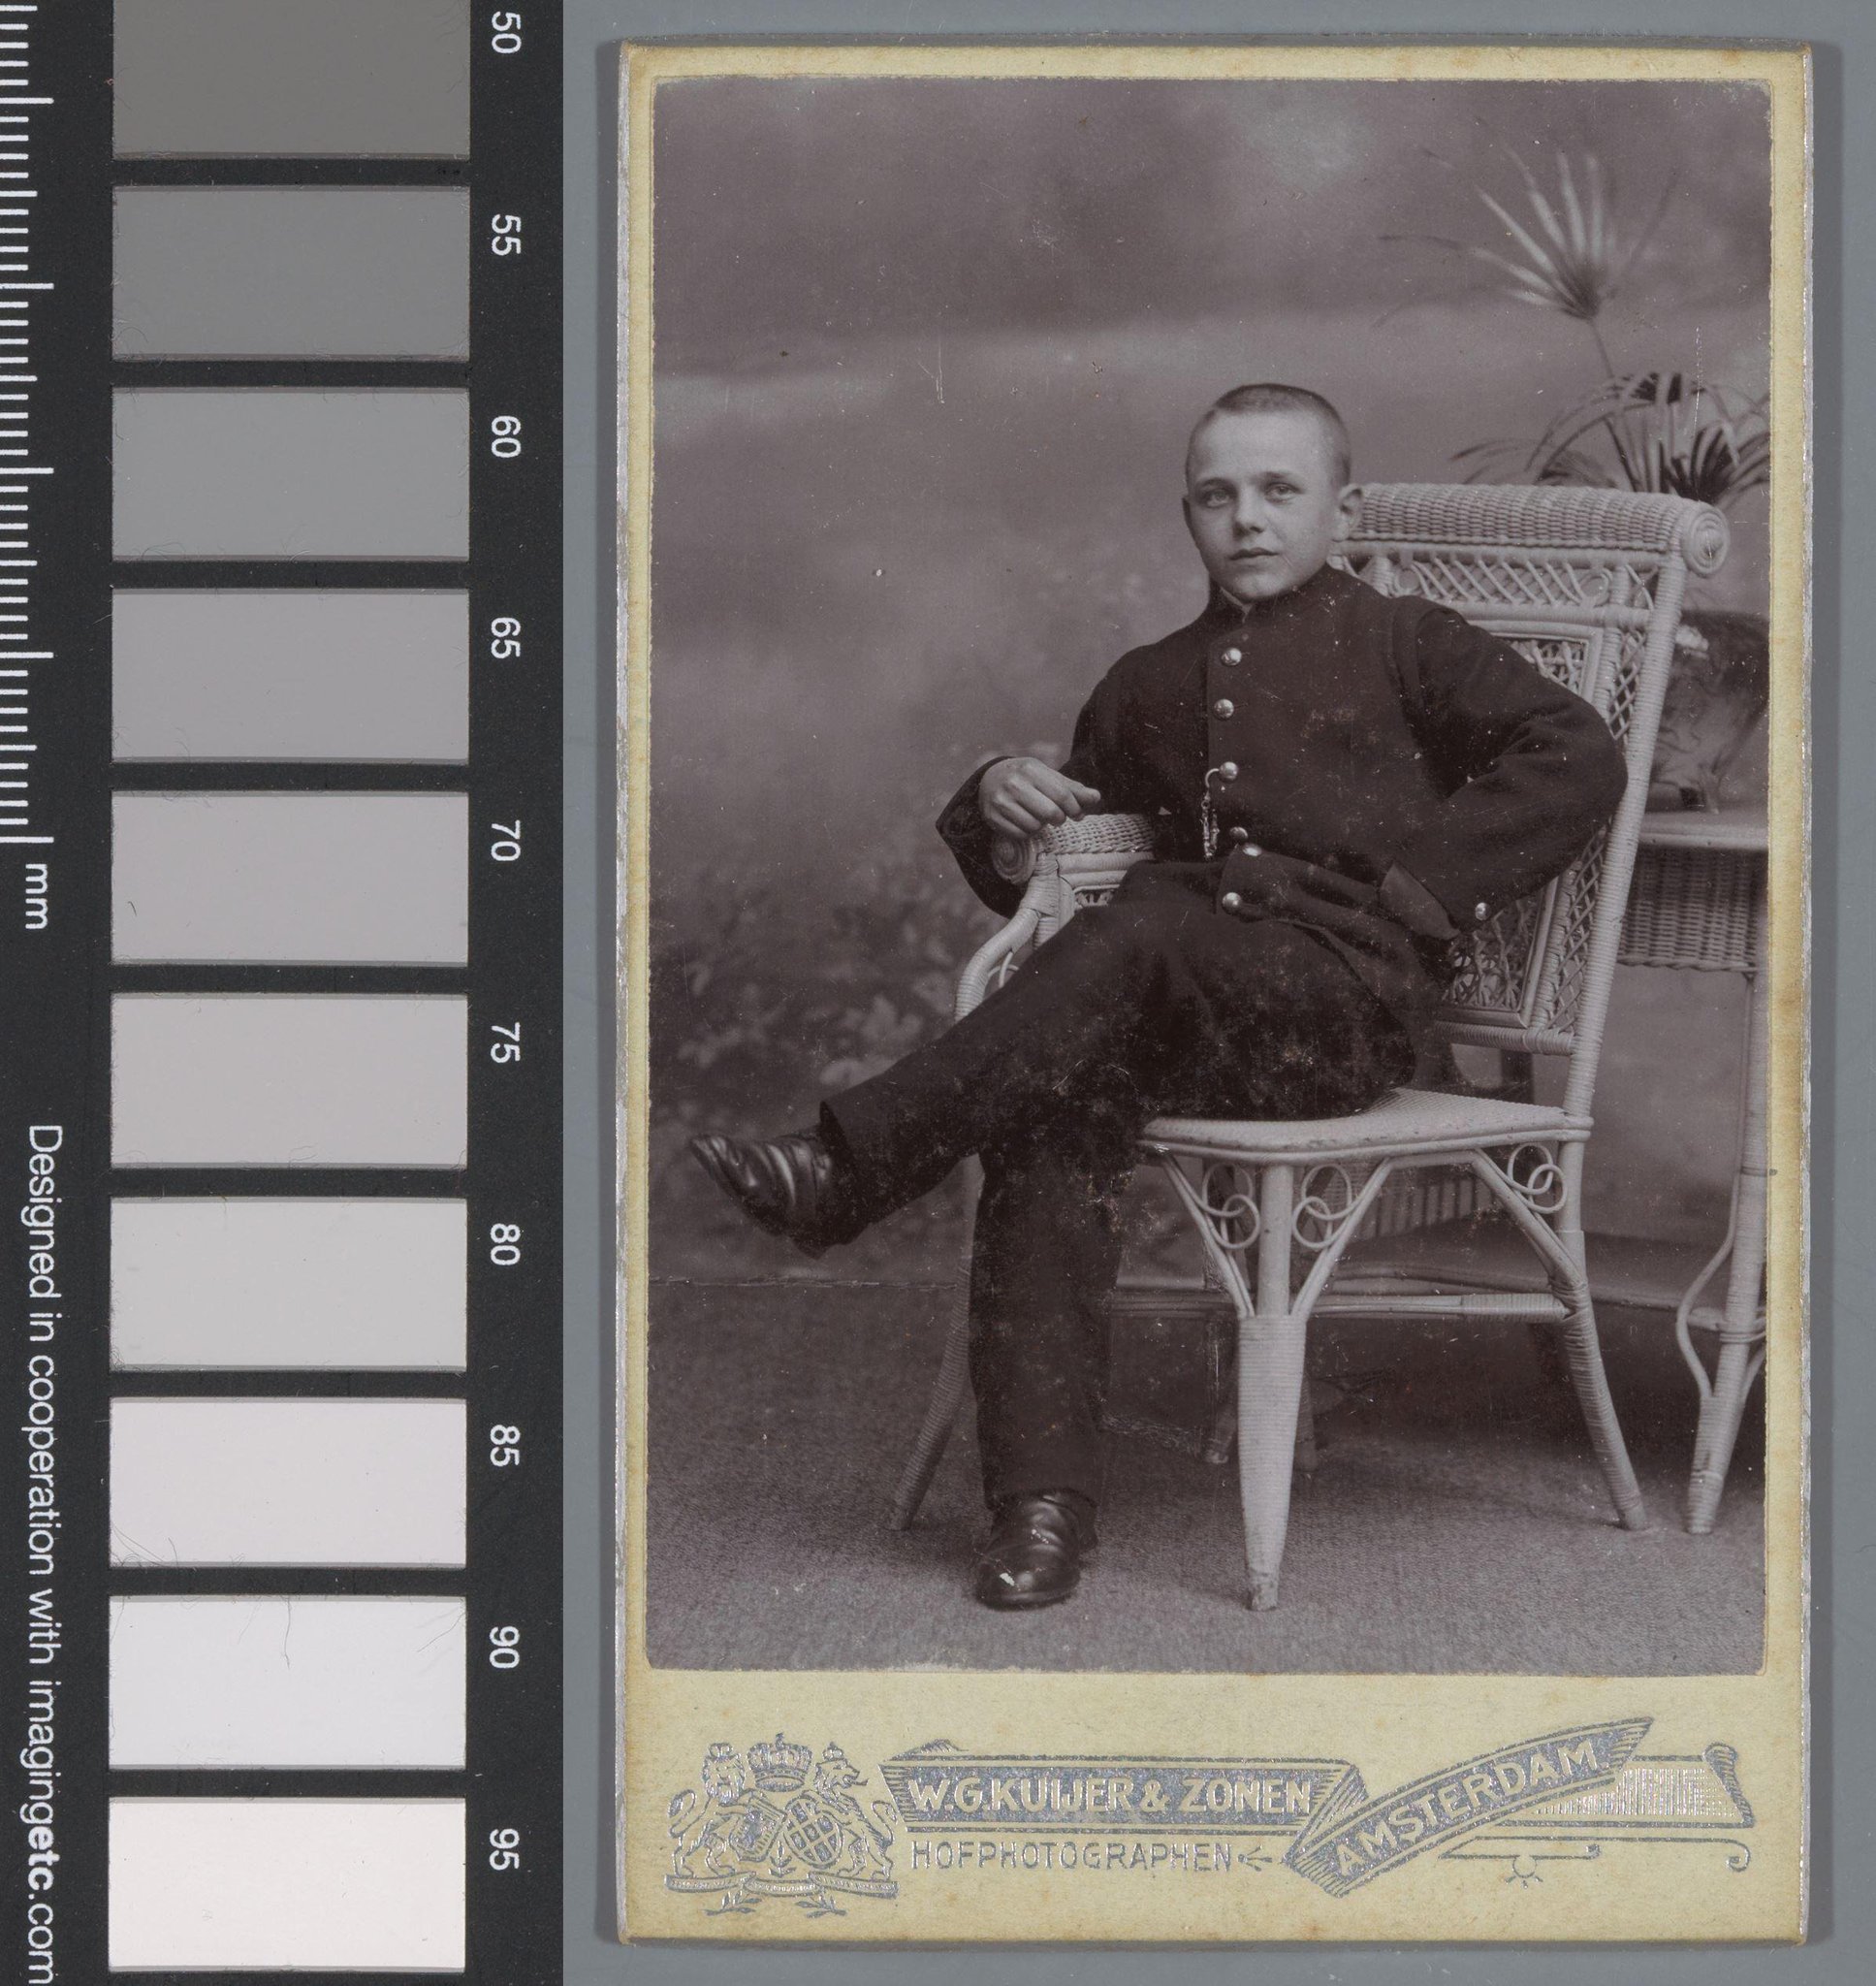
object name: carte de visite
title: Portret van een onbekende zittende jongen in uniform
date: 1885-1906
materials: paper, cardboard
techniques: collodion silver print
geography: amsterdam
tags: youth, adolescent, anonymous historical person portrayed, (military) uniforms, amsterdam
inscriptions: inscription: ‘W.G. Kuijer & Zonen/ Hofphotographen/ Amsterdam’, inscription: ‘Opgericht 1864/ W.G. Kuijer & Zonen/ Hofphotographen/ Amsterdam/ Westermarkt 19/ 18/ Spéciale inrichting voor vergrootingen in alle formaten.’